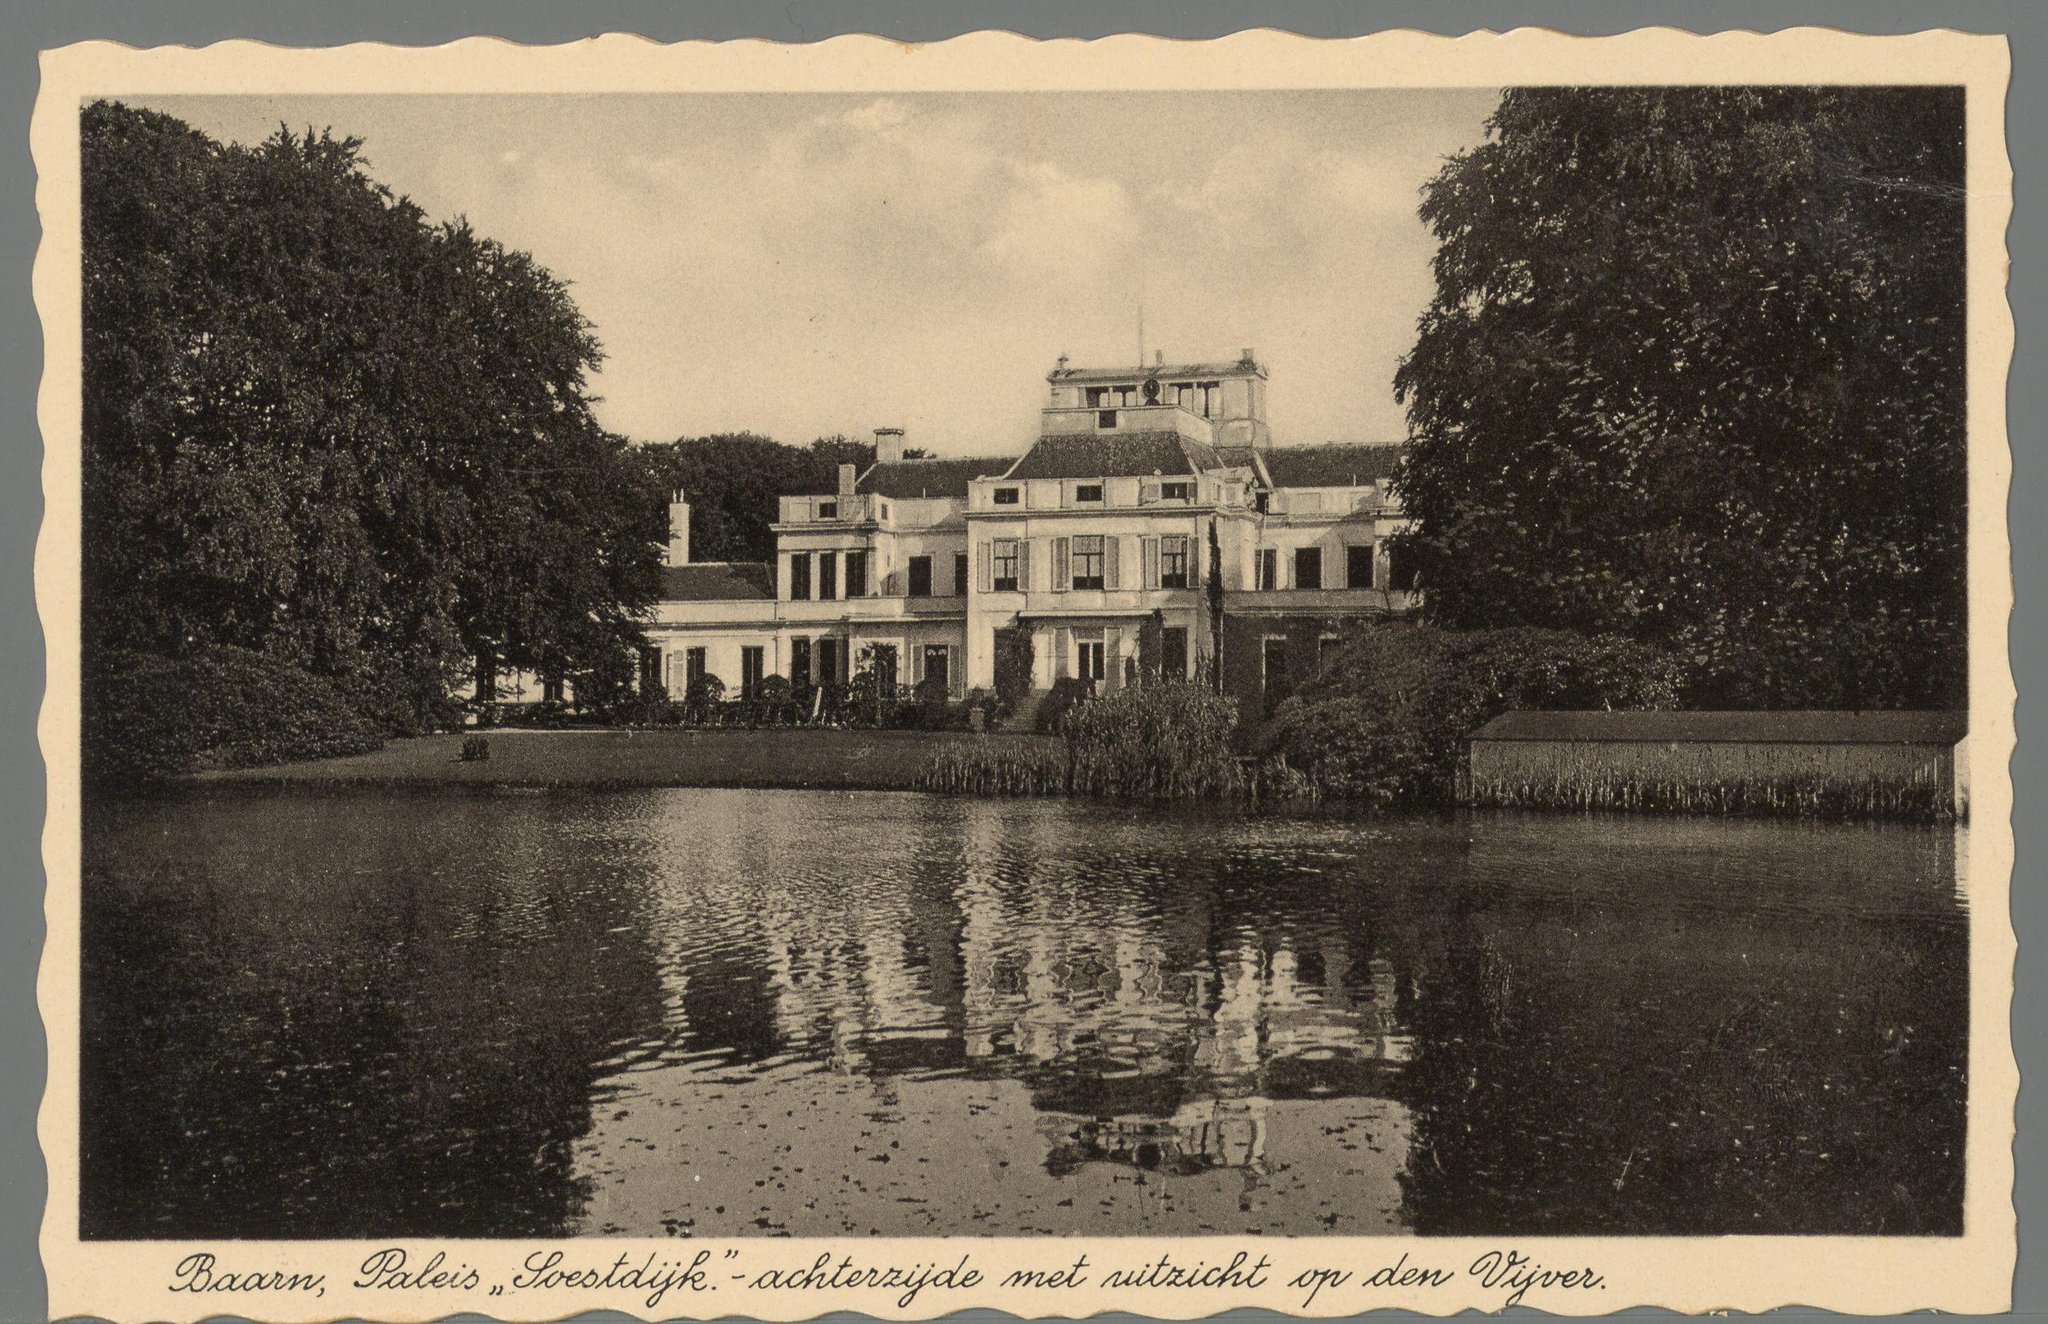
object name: photomechanical print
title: Baarn, Paleis "Soestdijk." - achterzijde met uitzicht op den vijver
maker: Anonymous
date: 1913-1950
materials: cardboard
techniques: photograph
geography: baarn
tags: palace, pond